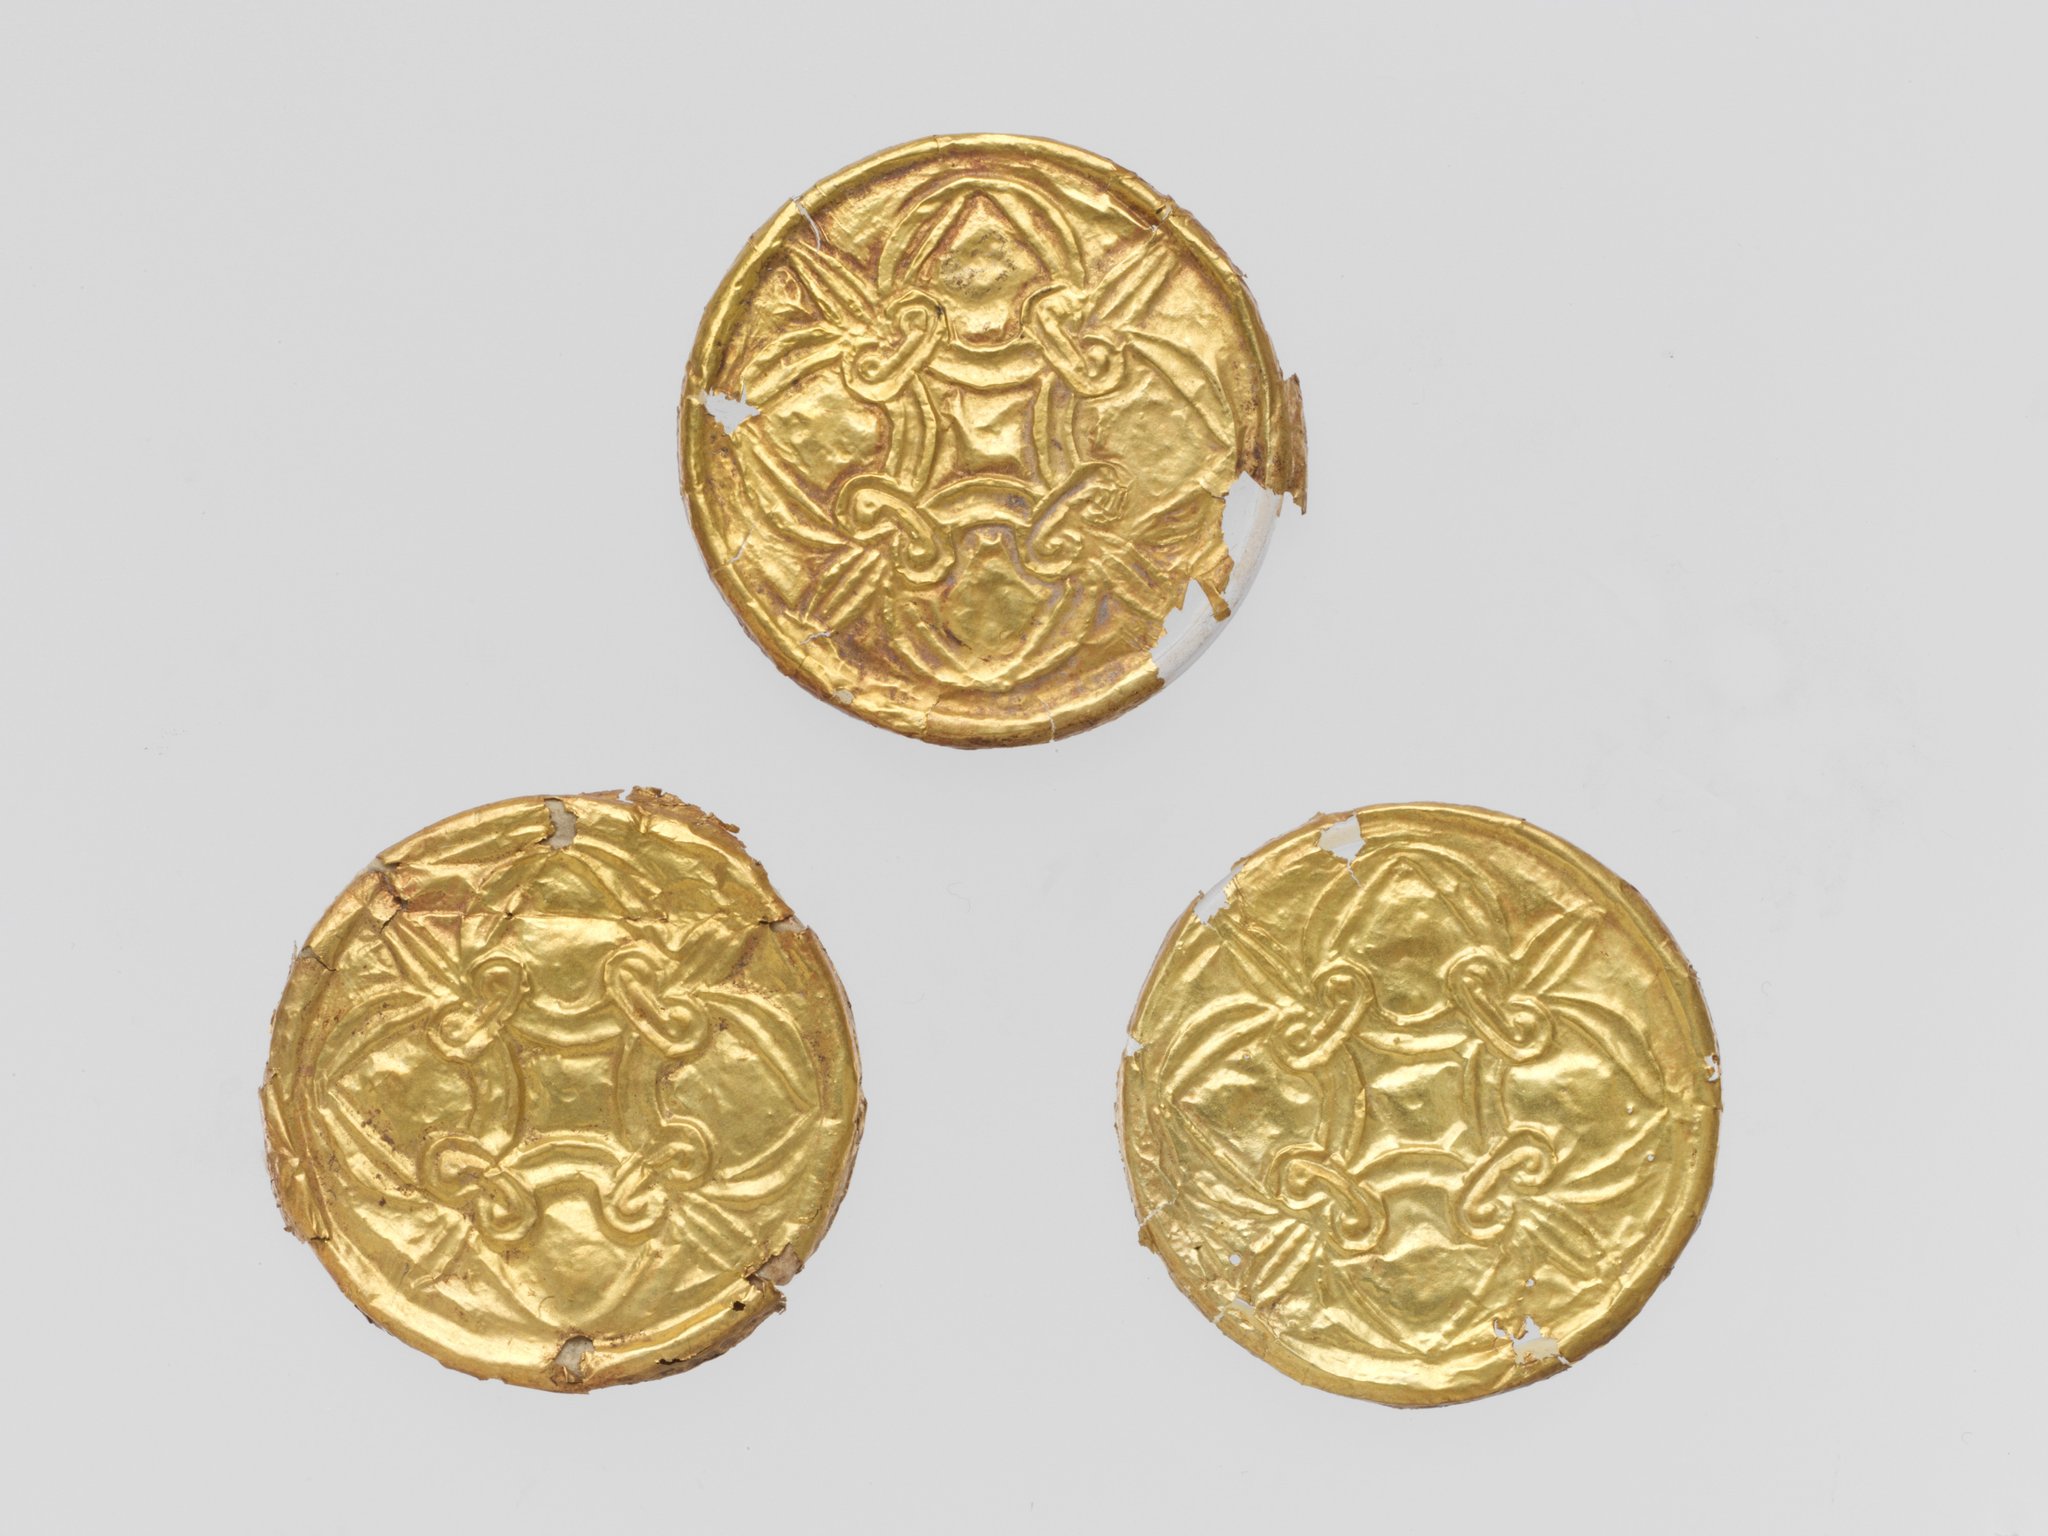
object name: roundel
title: Gold roundel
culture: cypriot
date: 1600-1050 BCE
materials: gold